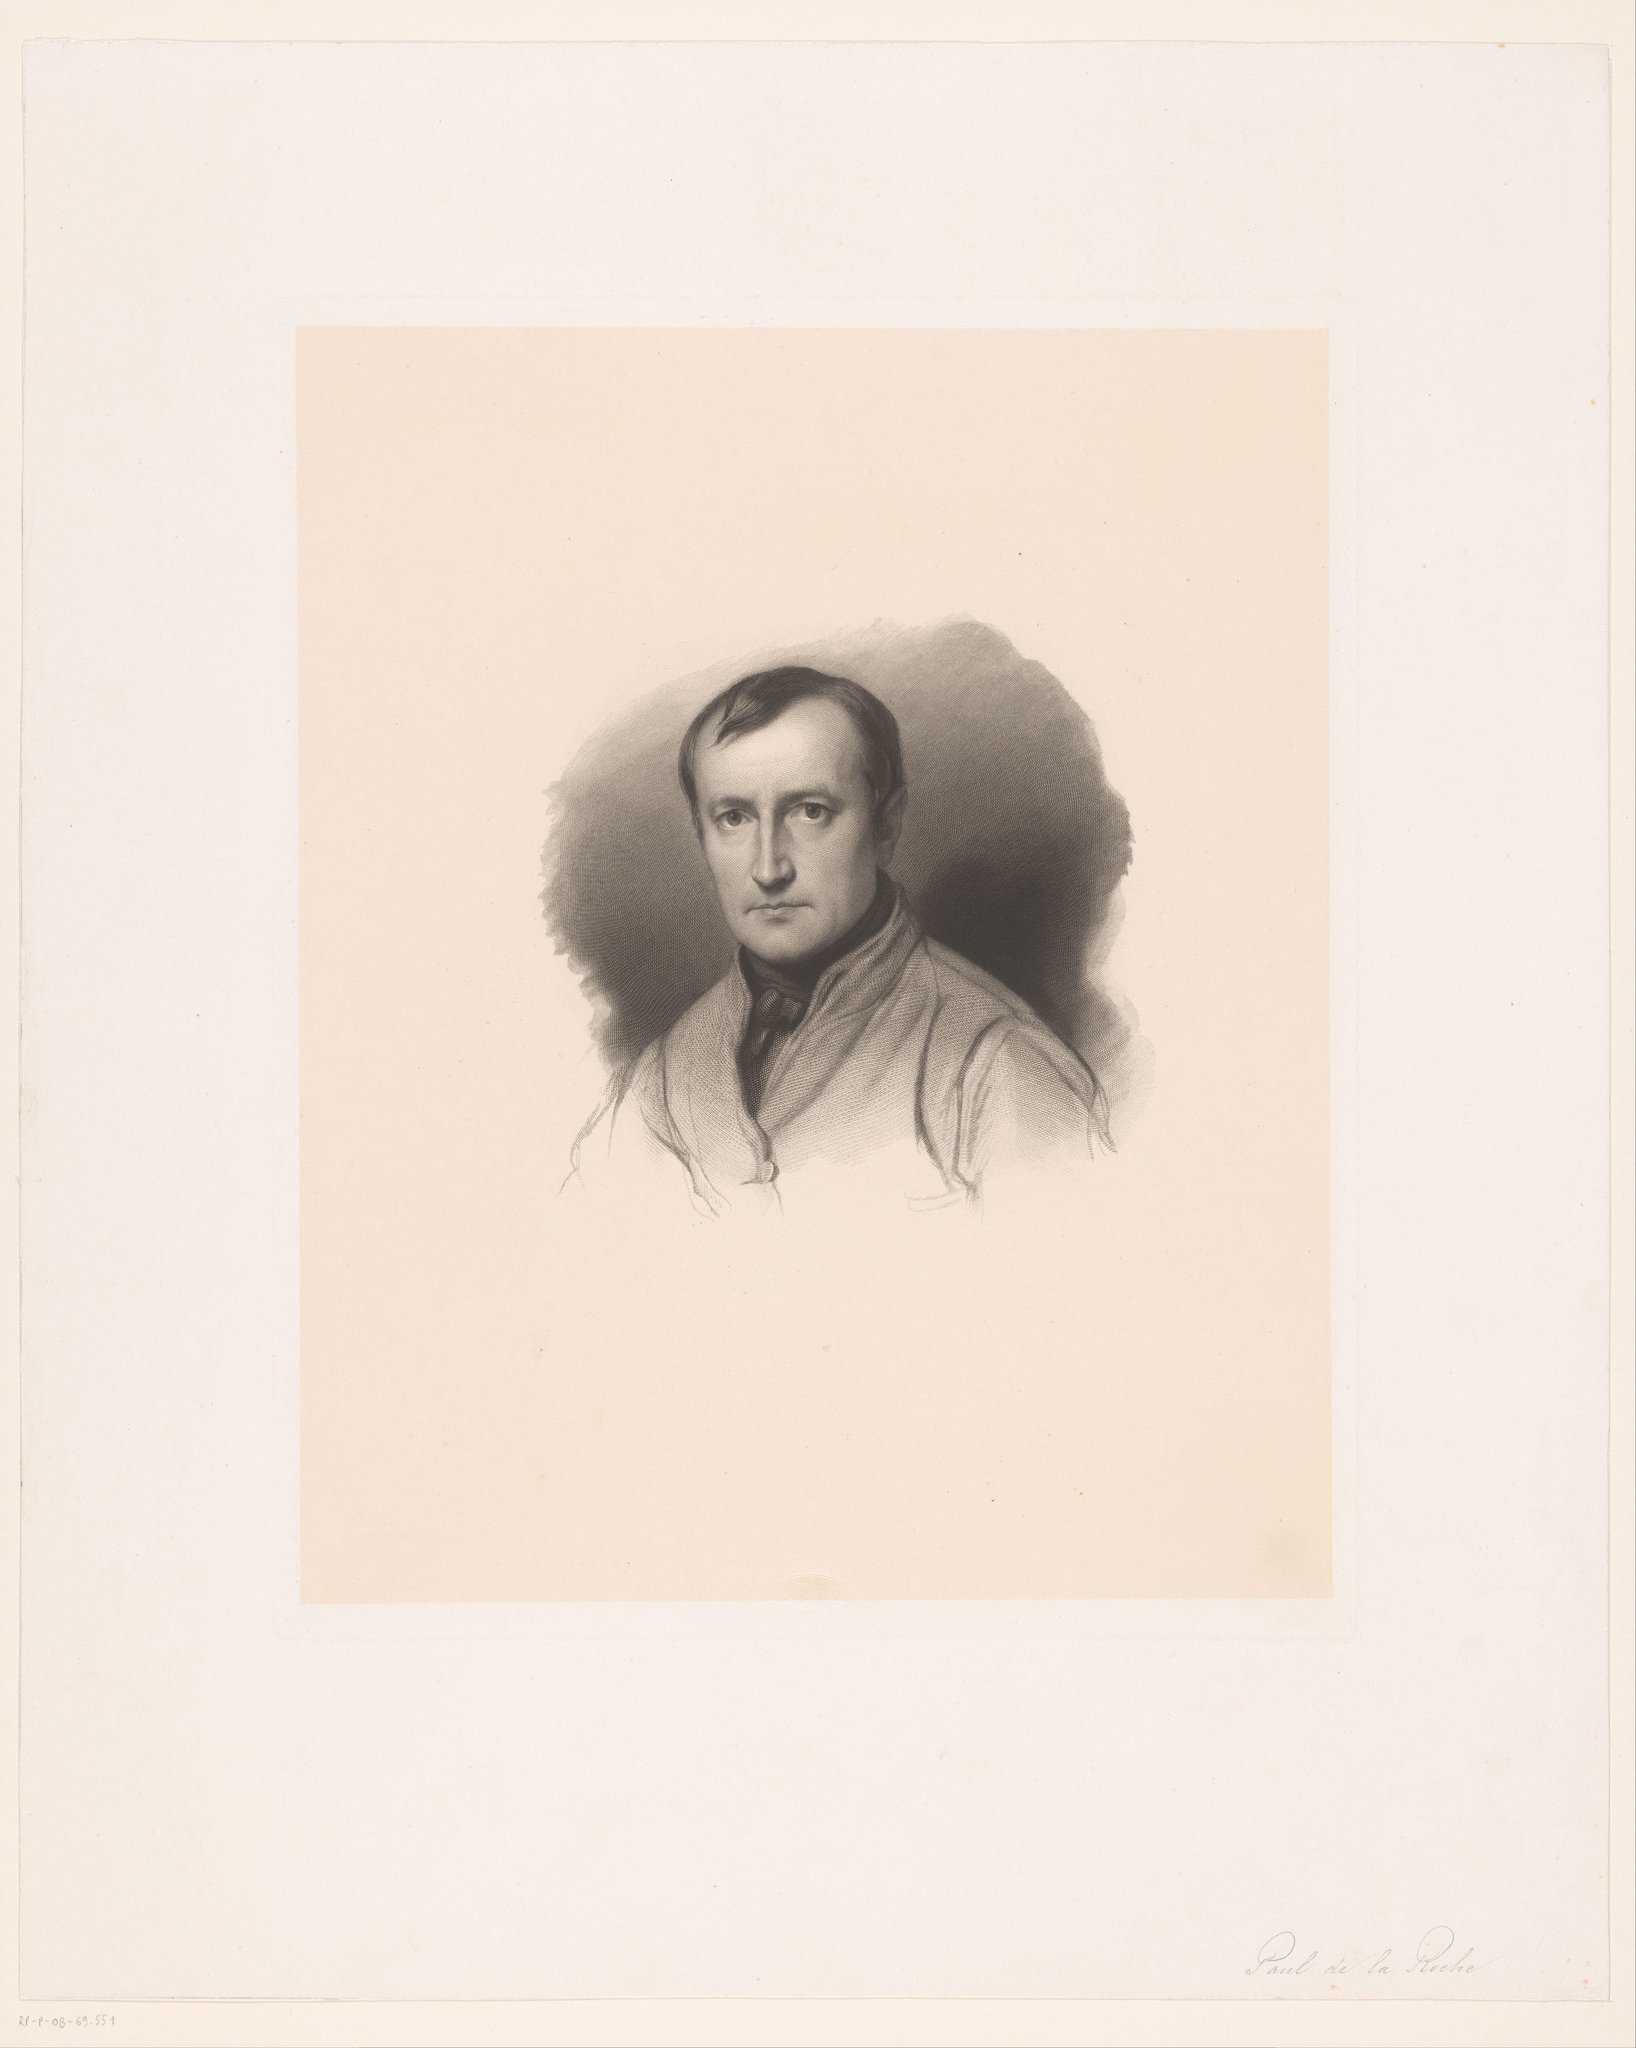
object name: print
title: Portret van Paul Delaroche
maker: aristide louis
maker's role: print maker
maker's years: 1815-1852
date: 1845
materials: paper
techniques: engraving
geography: france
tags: paris, painter, draughtsman, sculptor, paul delaroche, historical persons, portrait, self-portrait of painter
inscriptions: collector's mark: Lugt 12, check stamp: Lugt 5003